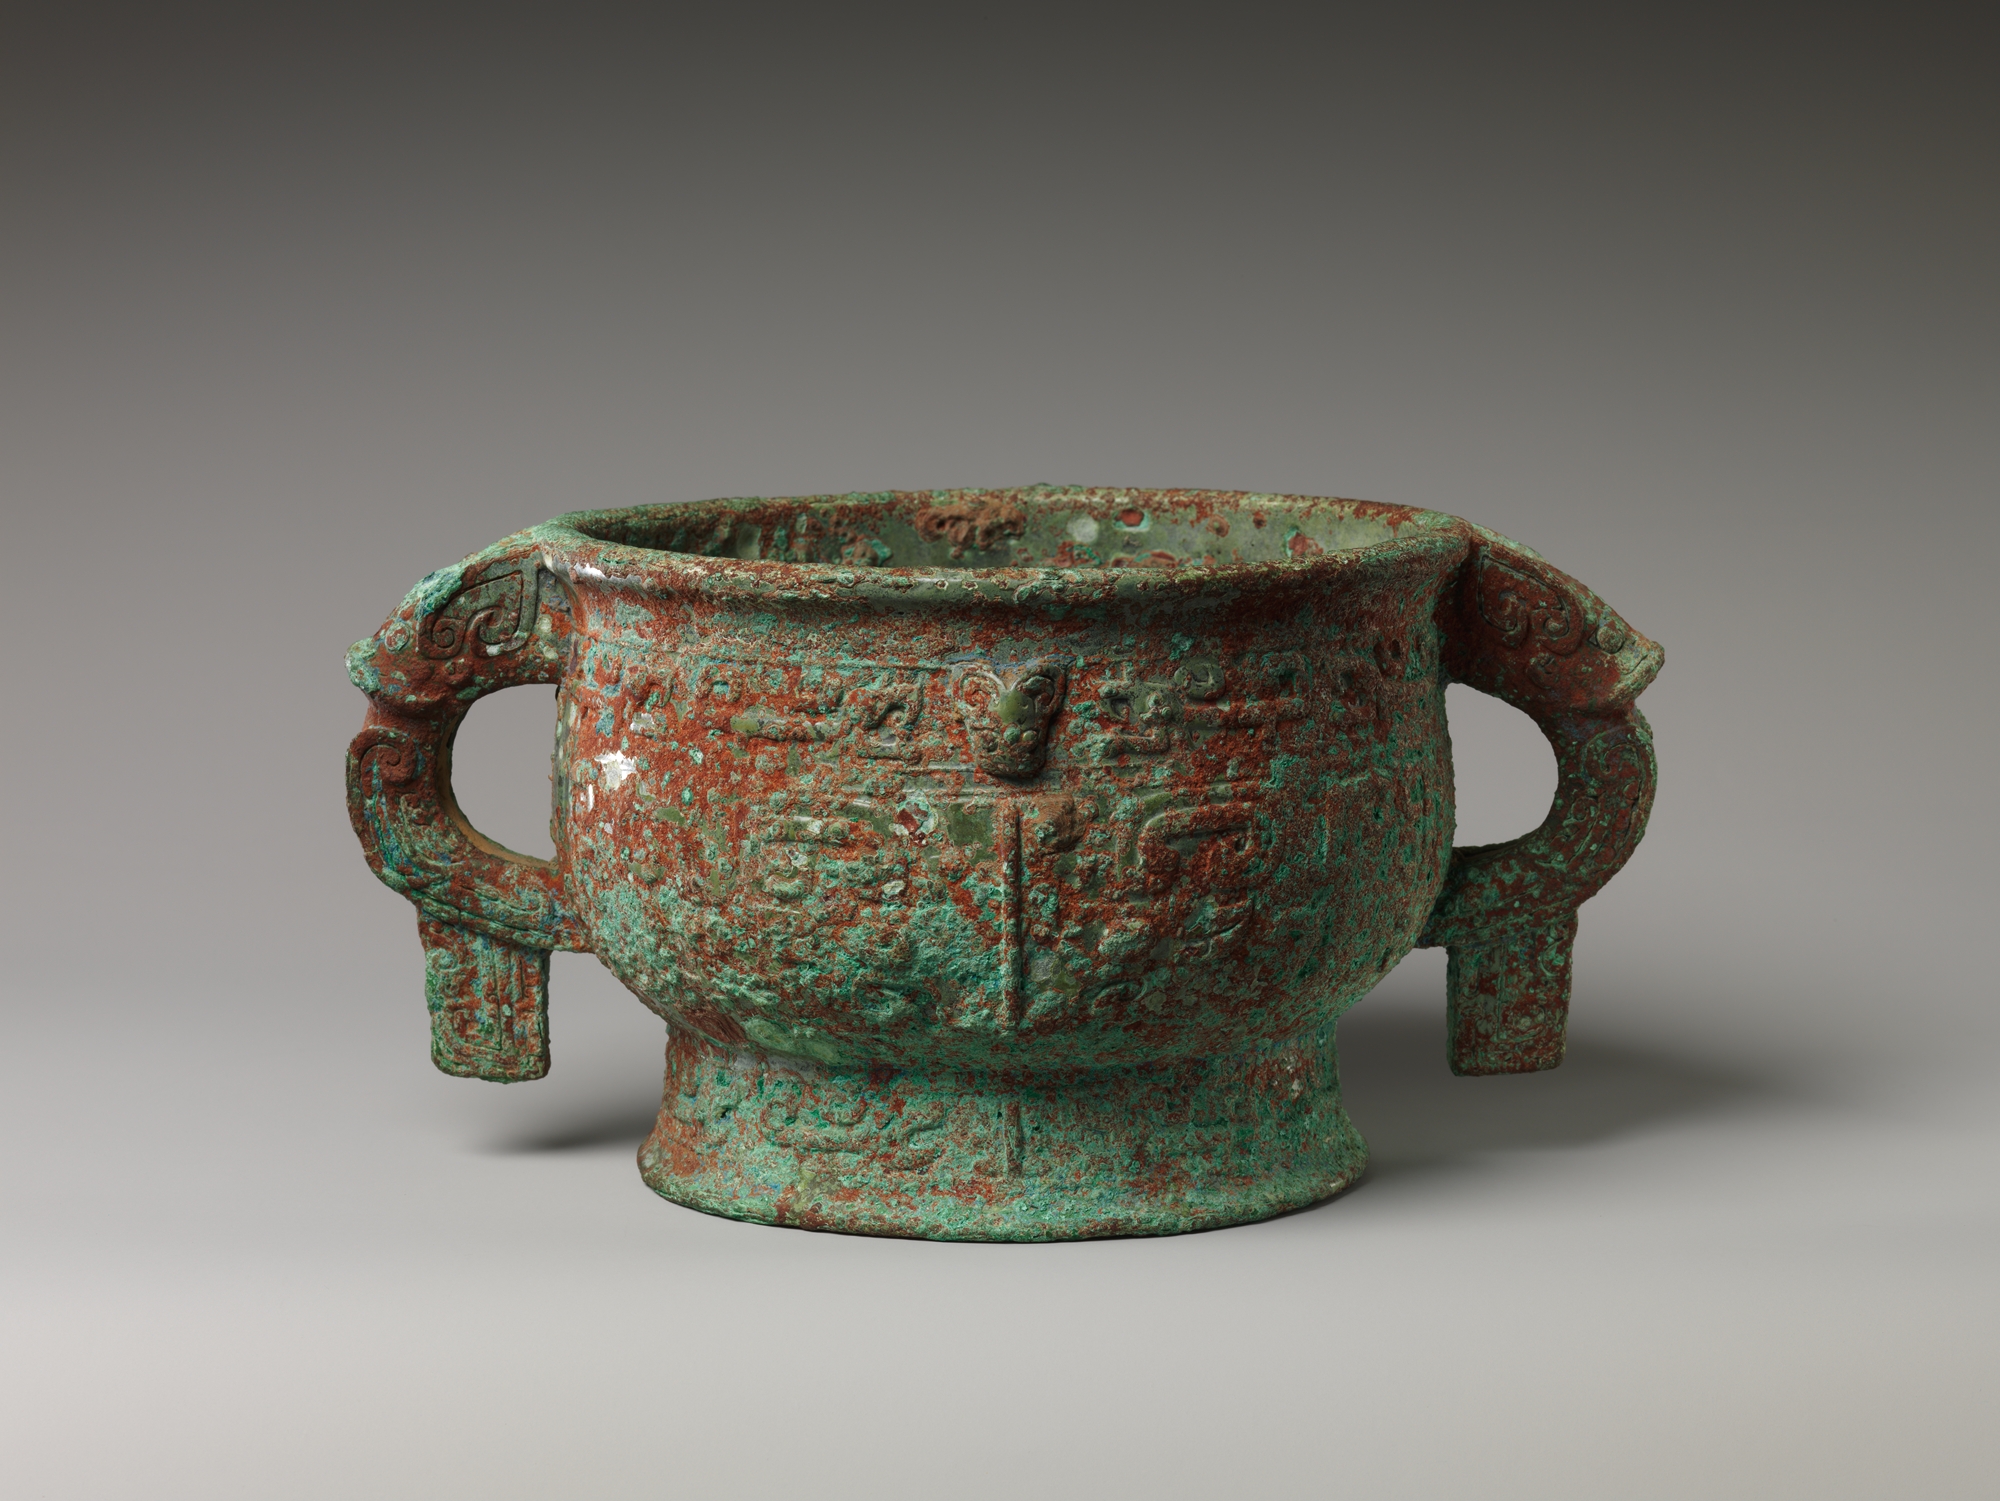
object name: food vessel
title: Grain serving vessel (Gui)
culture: chinese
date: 1100-901 BCE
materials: bronze